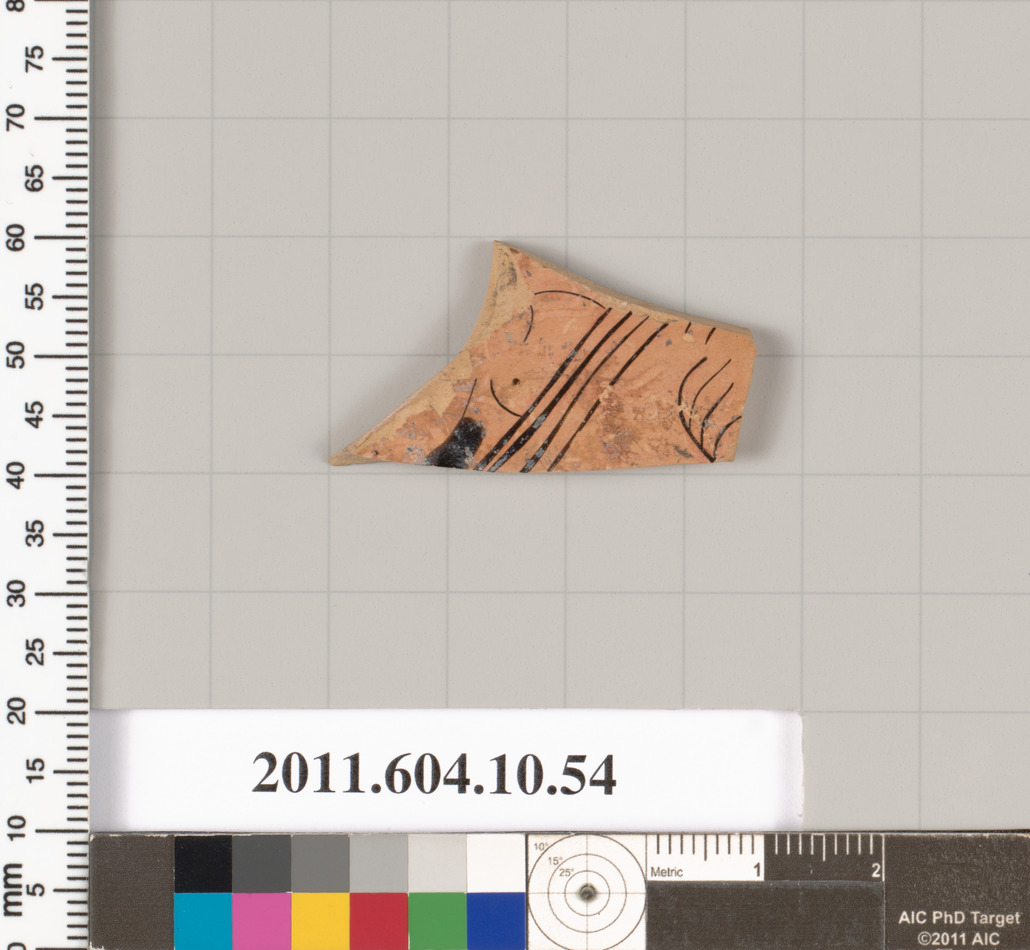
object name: kylix fragment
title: Terracotta fragment of a kylix (drinking cup)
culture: etruscan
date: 334-301 BCE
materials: terracotta